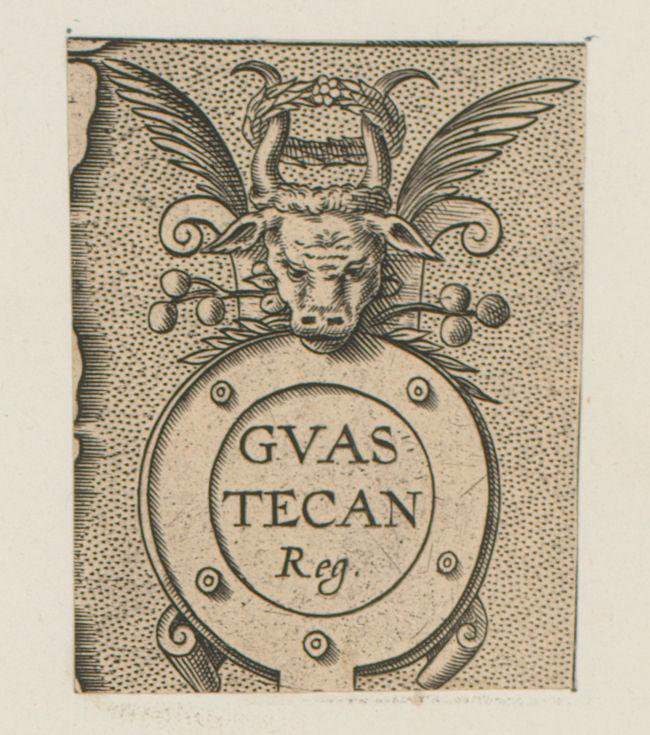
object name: print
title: Guastecan Reg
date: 1584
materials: paper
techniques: engraving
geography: antwerp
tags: cow, ornament ~ cartouche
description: Ronde cartouche met bovenaan een koe met een lauwerkrans om zijn horens en twee palmtakken. De cartouche is een fragment van een kaart van Perua, Florida en Huasteca. De prent maakt deel uit van een album.